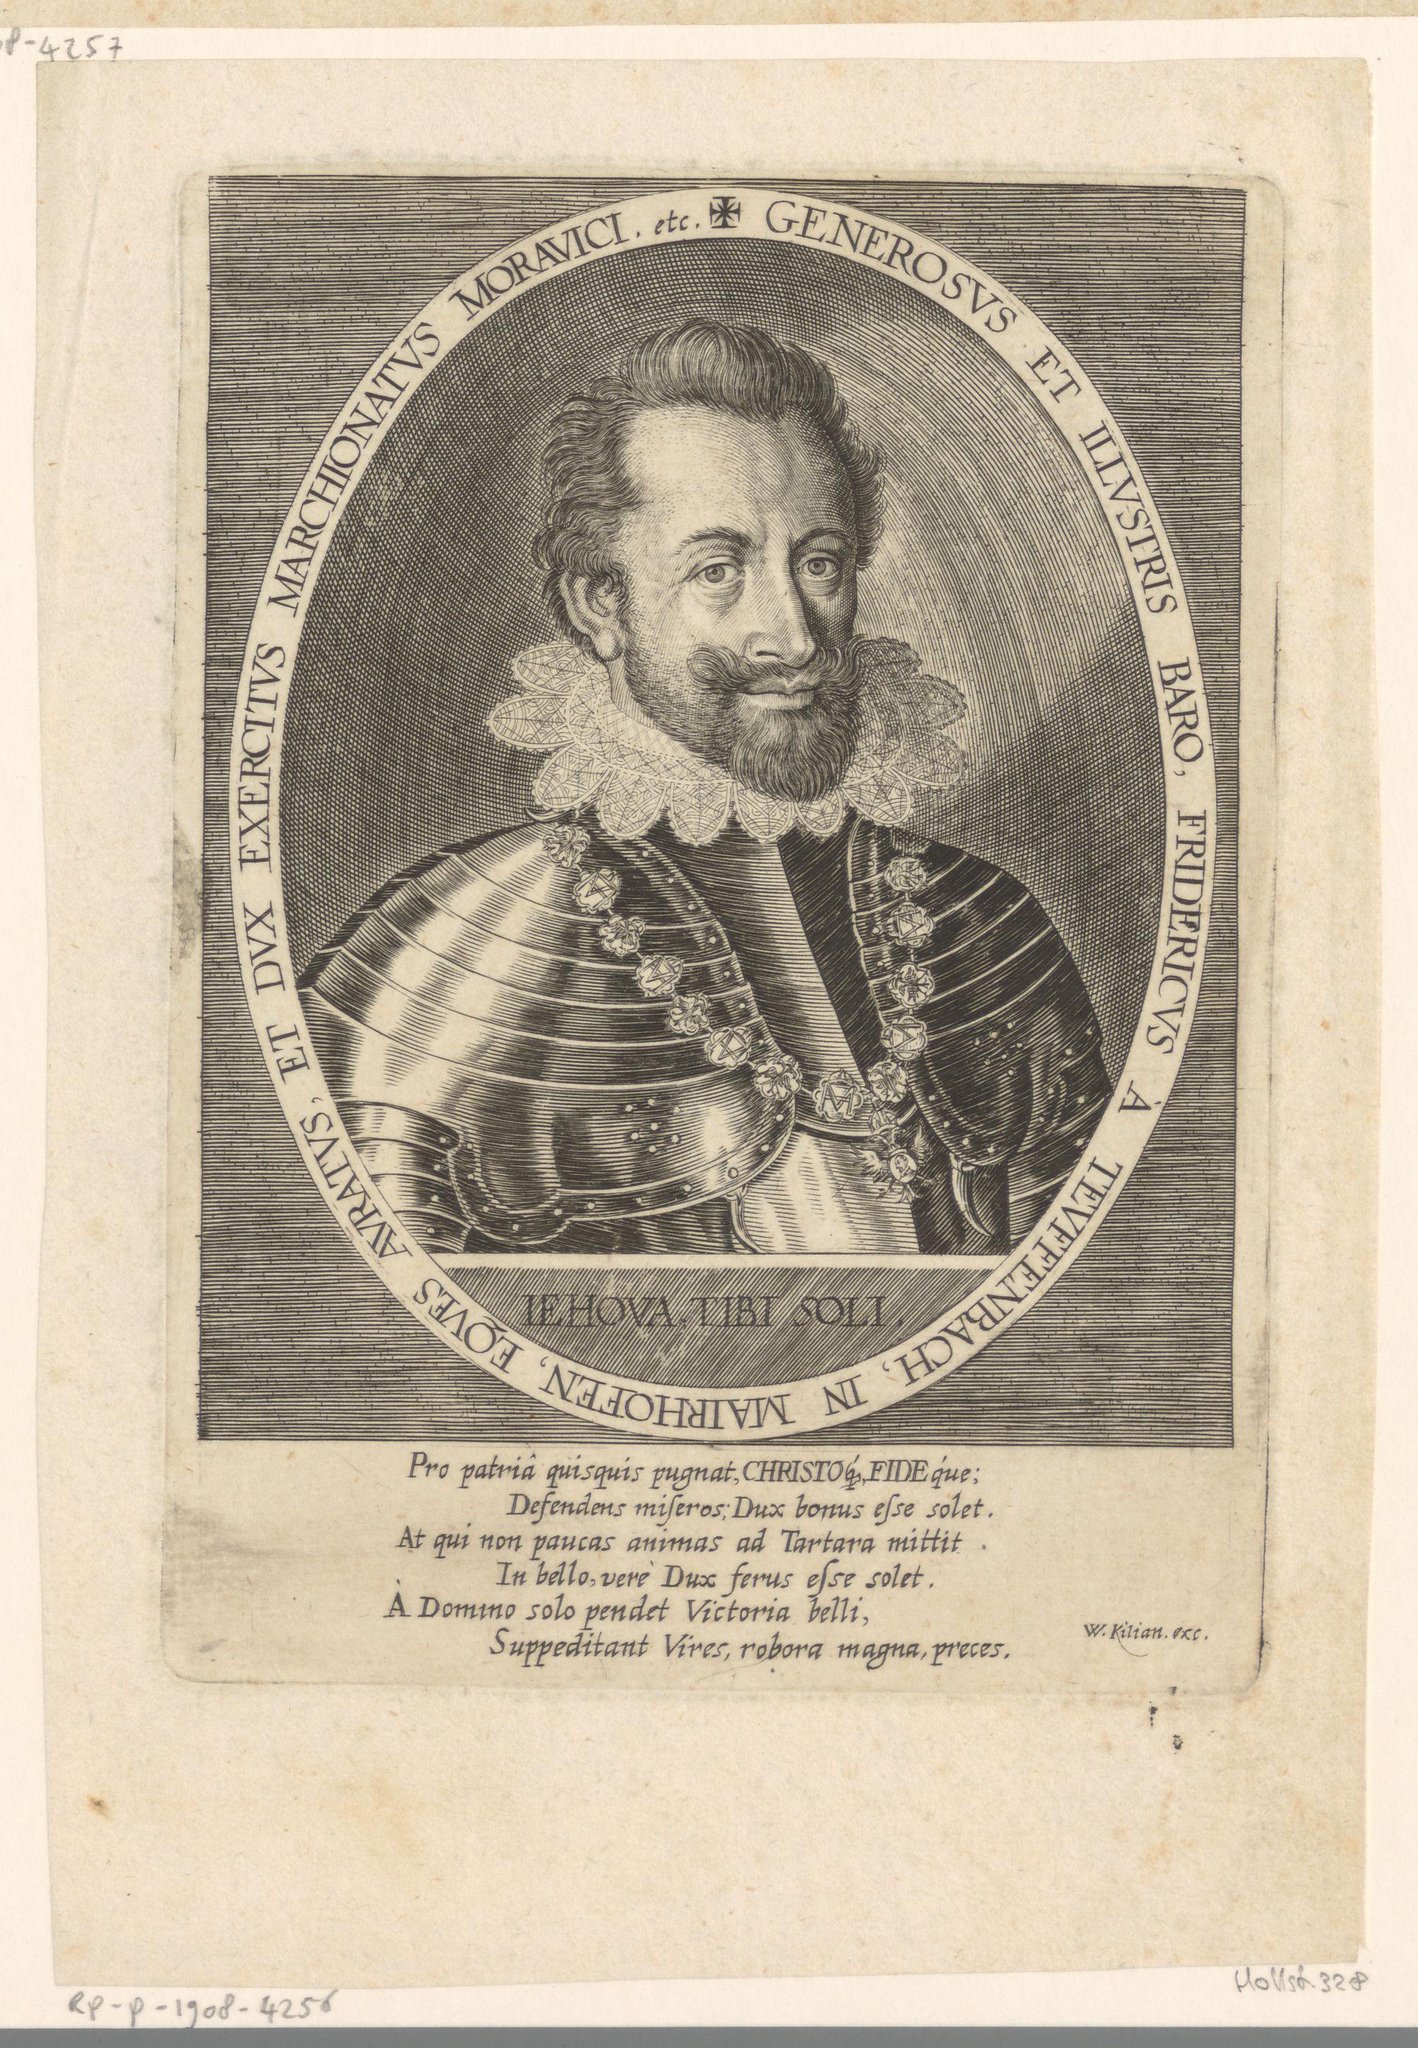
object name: print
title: Portret van Friedrich von Teuffenbach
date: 1619-1662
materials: paper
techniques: engraving, etching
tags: treasurer, commander-in-chief, general, marshal, historical persons, medals and other marks of military honour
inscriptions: collector's mark: Lugt 2228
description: Tekst in het Latijn in de omlijsting en in de ondermarge.